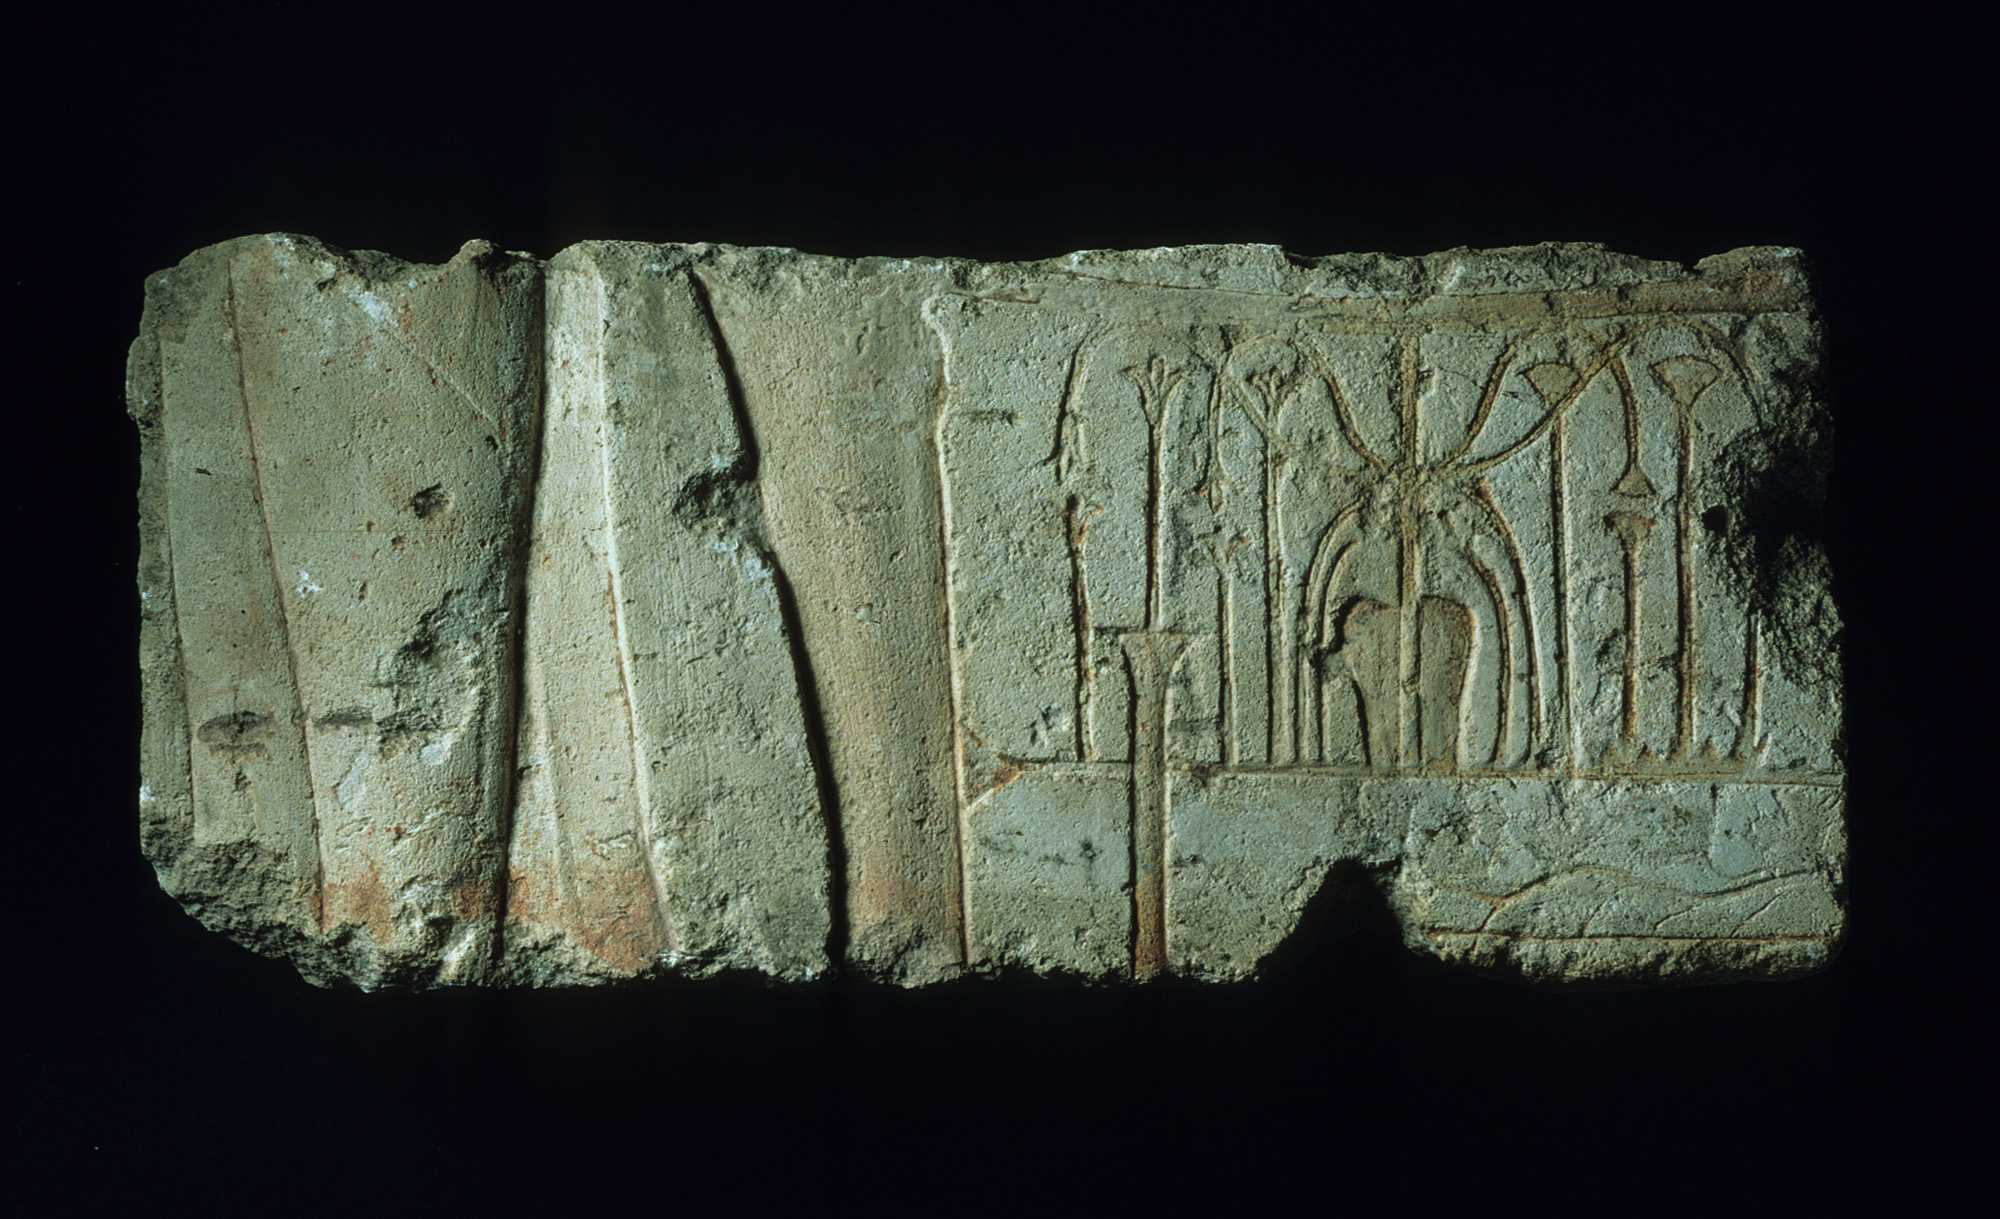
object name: talatat, royal figure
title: Relief with a royal figure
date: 1353-1336 BCE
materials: limestone, paint